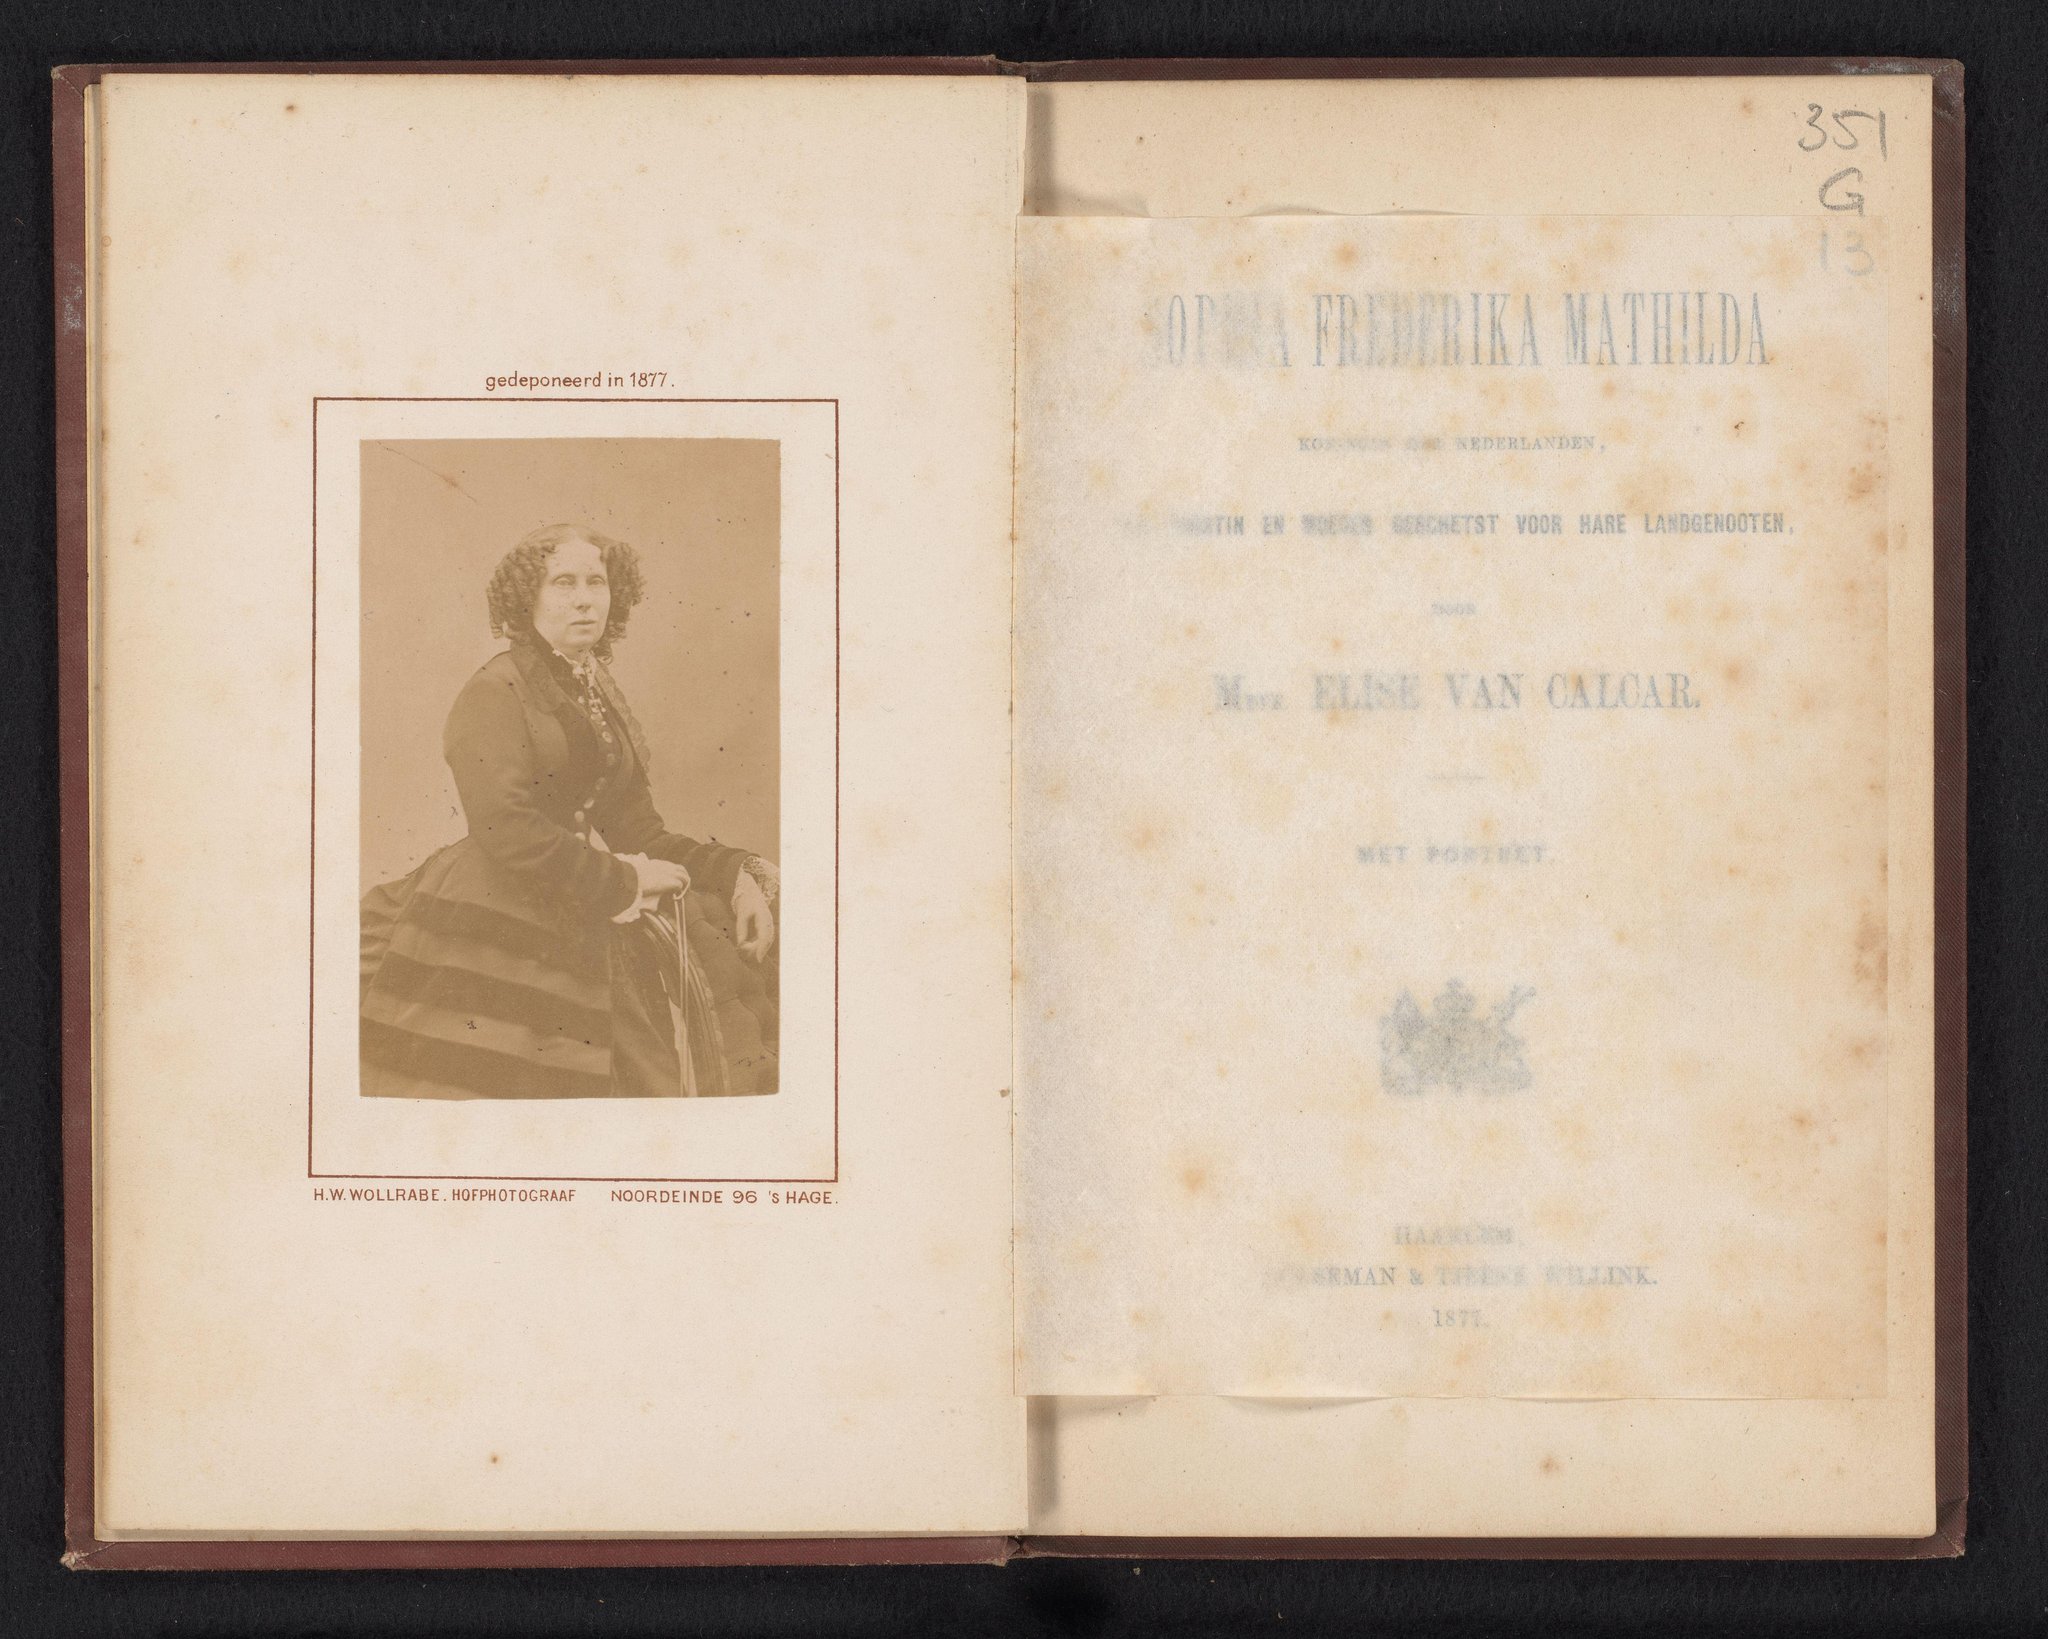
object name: photograph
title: Portret van Sophia Frederika Mathilda, koningin der Nederlanden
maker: heinrich wilhelm wollrabe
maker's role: fotograaf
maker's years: 1843-1928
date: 1870-1877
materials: paper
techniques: albumen print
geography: the hague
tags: the hague, sophia frederika mathilda van württemberg, historical persons - bb - woman, queen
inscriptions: address: ‘H.W. WOLLRABE. HOFPHOTOGRAAF NOORDEINDE 96 'S HAGE.’, inscription: ‘gedepondeerd in 1877.’